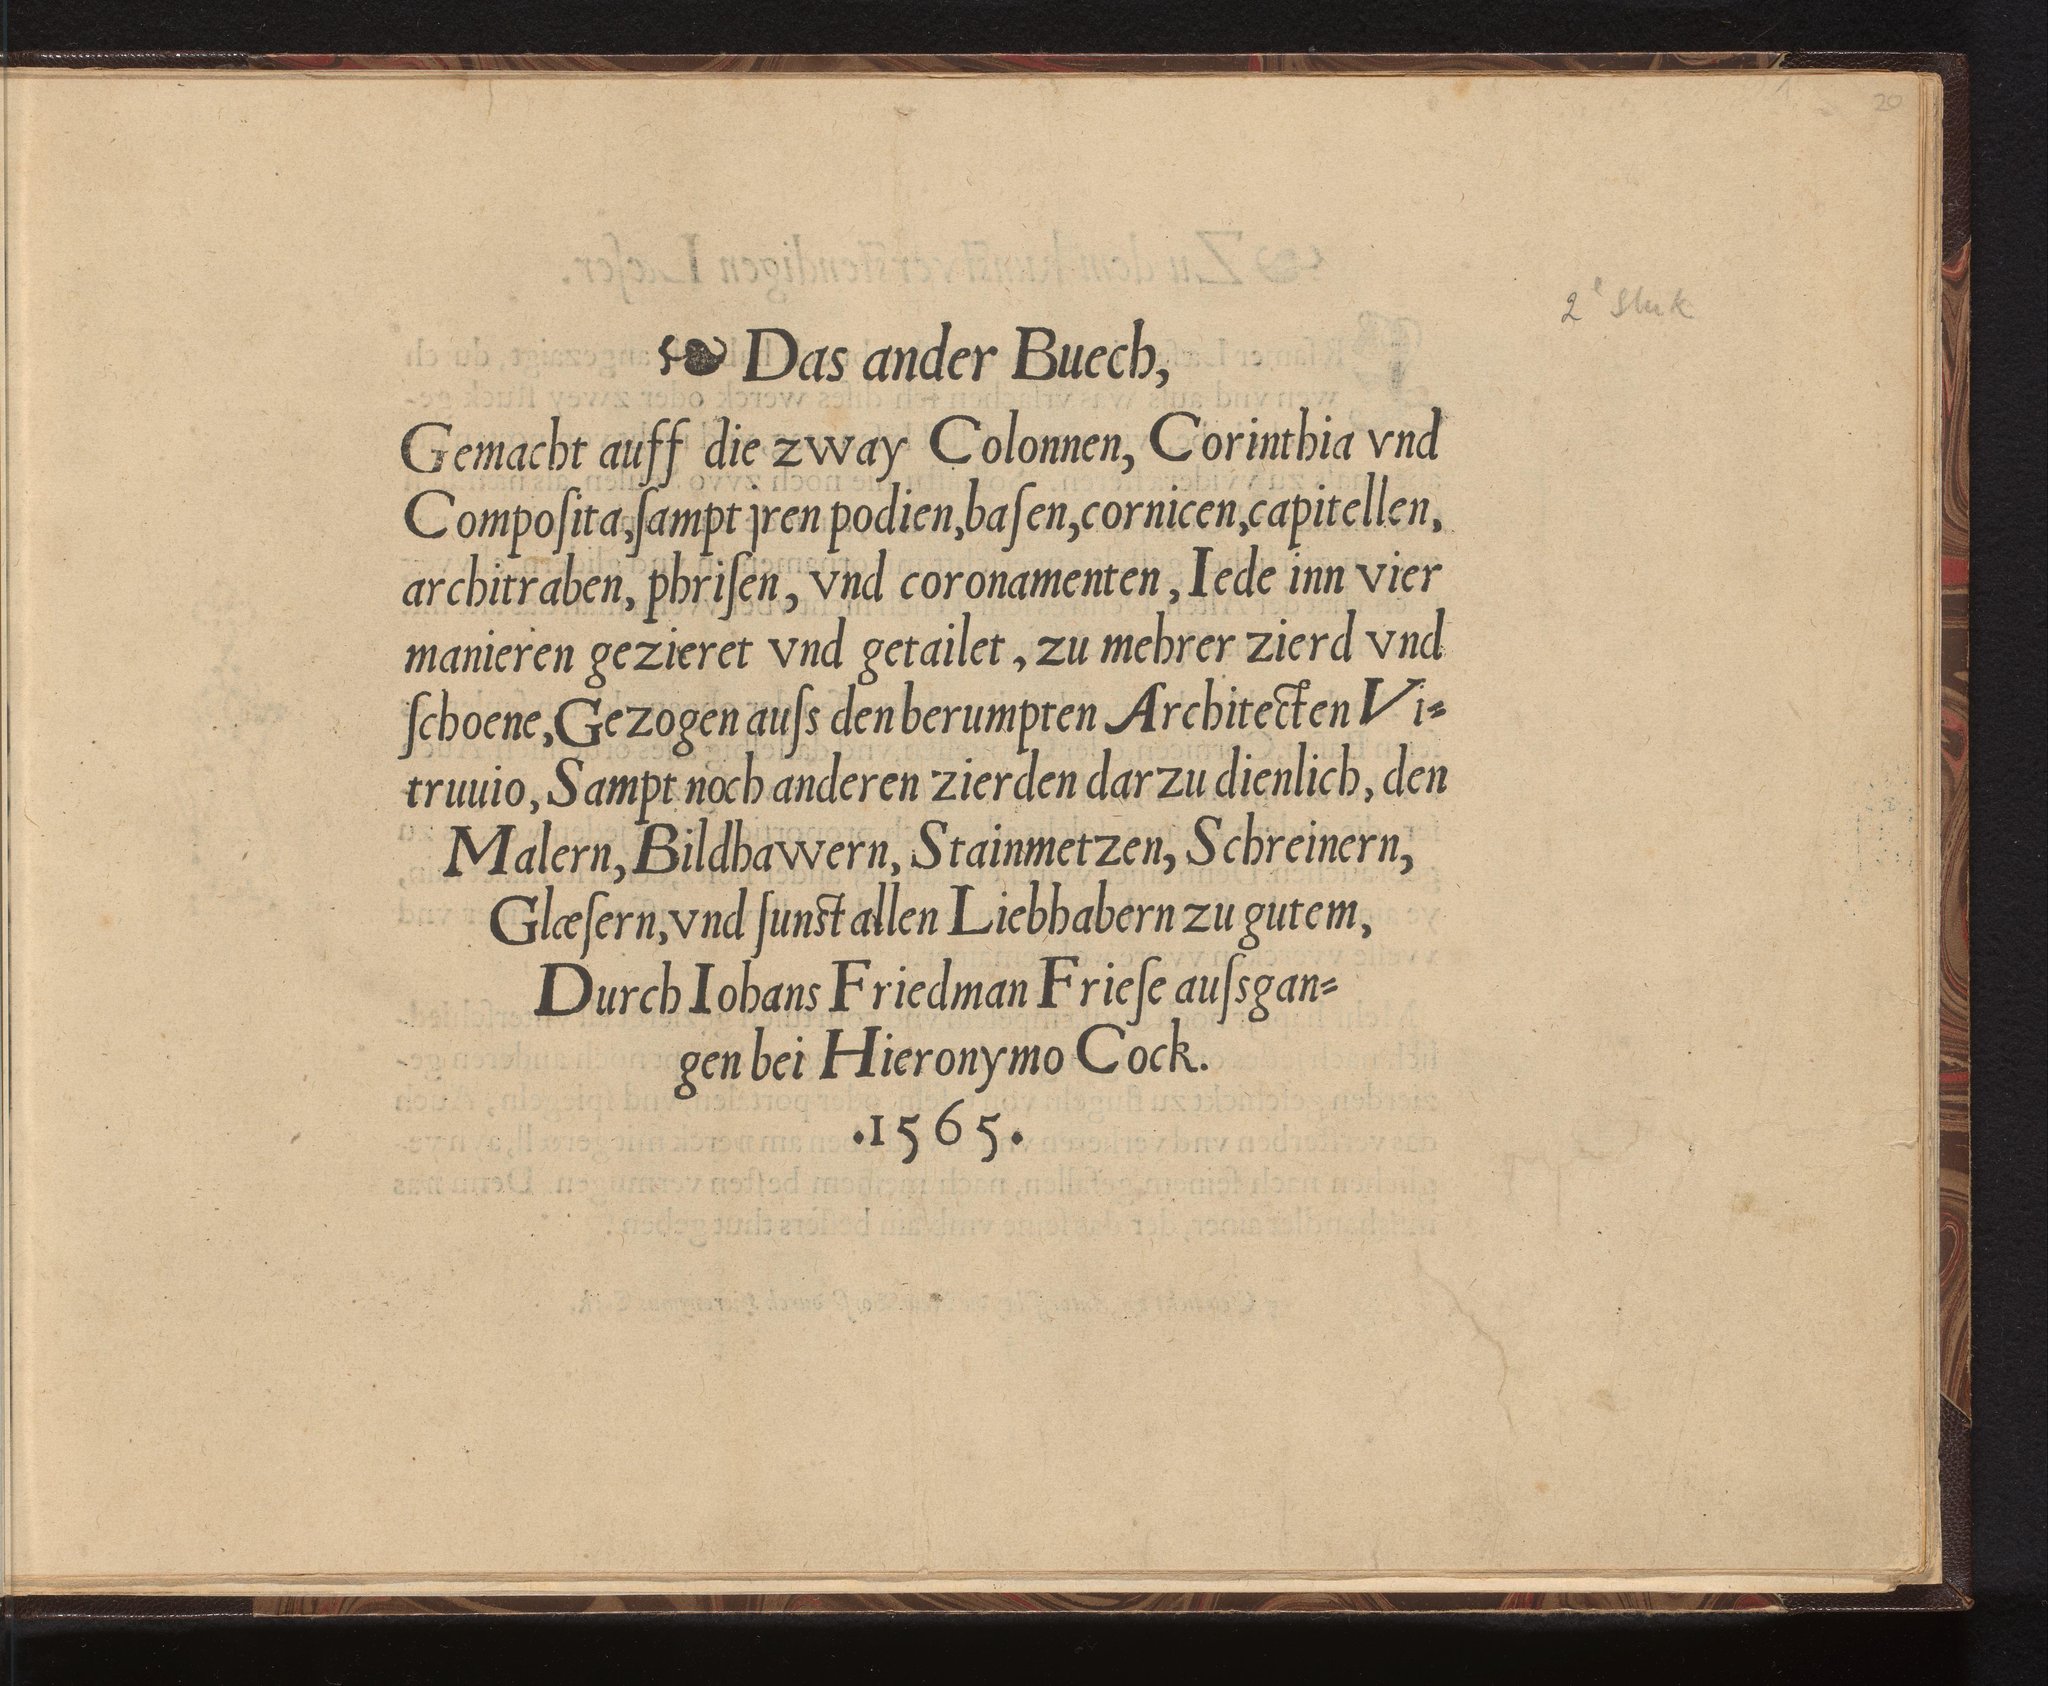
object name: album leaf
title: Titelpagina voor: Das ander Buech gemacht auff die zway Colonnen, Corinthia und Composita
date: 1565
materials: paper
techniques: letterpress printing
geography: antwerp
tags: title-page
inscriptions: date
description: Titelpagina voor de serie: Das ander Buech gemacht auff die zway Colonnen, Corinthia und Composita ... De voorstellingen zijn volgens de tekst bedoeld voor schilders, beeldhouwers, steenhouwers, schrijnwerkers, glasmakers en allen kunstliefhebbers. Het blad maakt deel uit van een album.